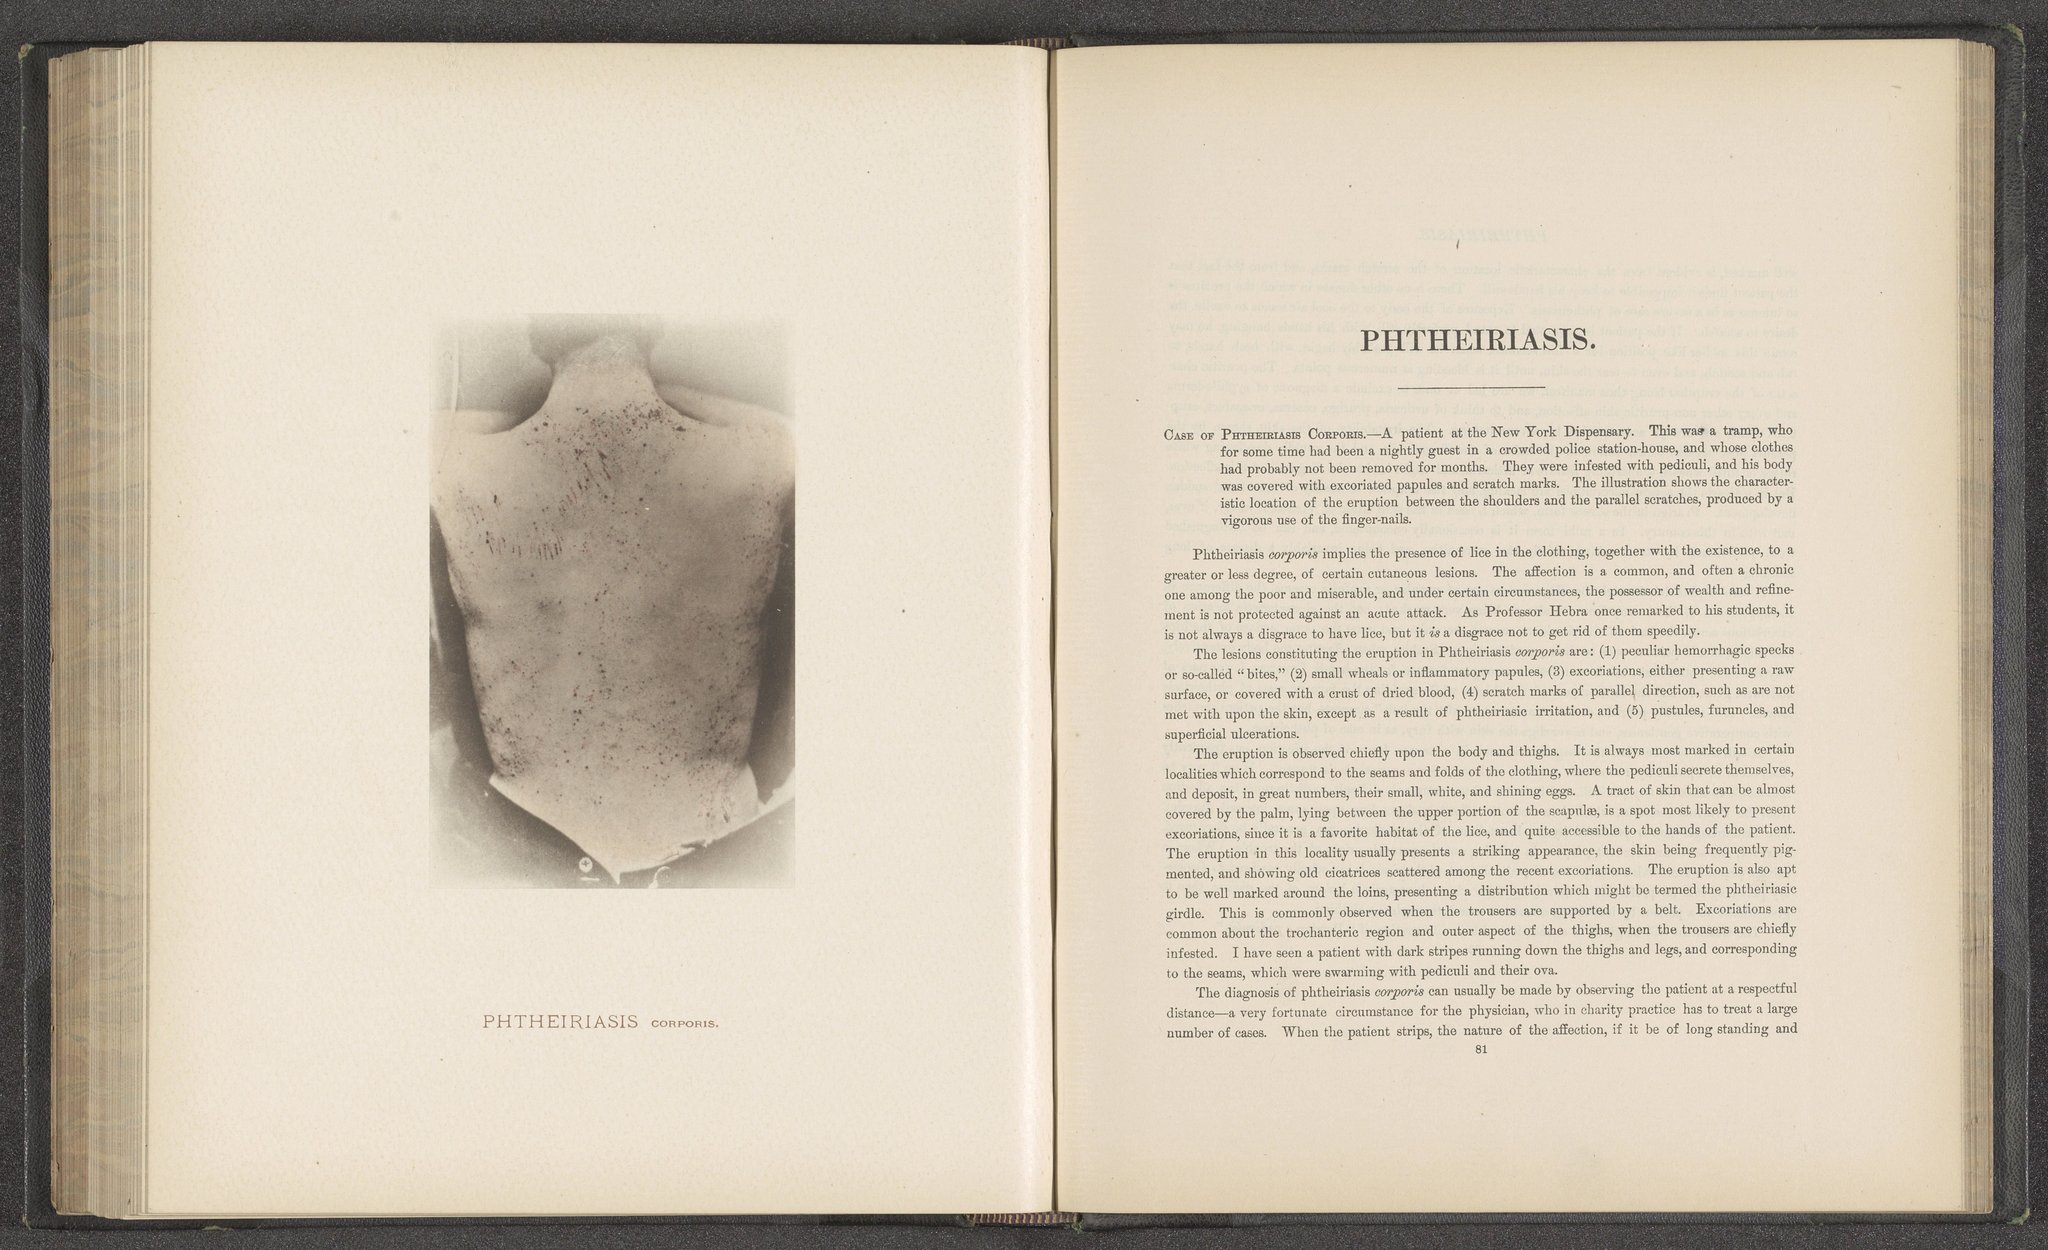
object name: page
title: Phtheiriasis corporis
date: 1870-1881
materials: paper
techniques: photograph, hand coloring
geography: new york city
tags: skin and venereal diseases, adult man, back